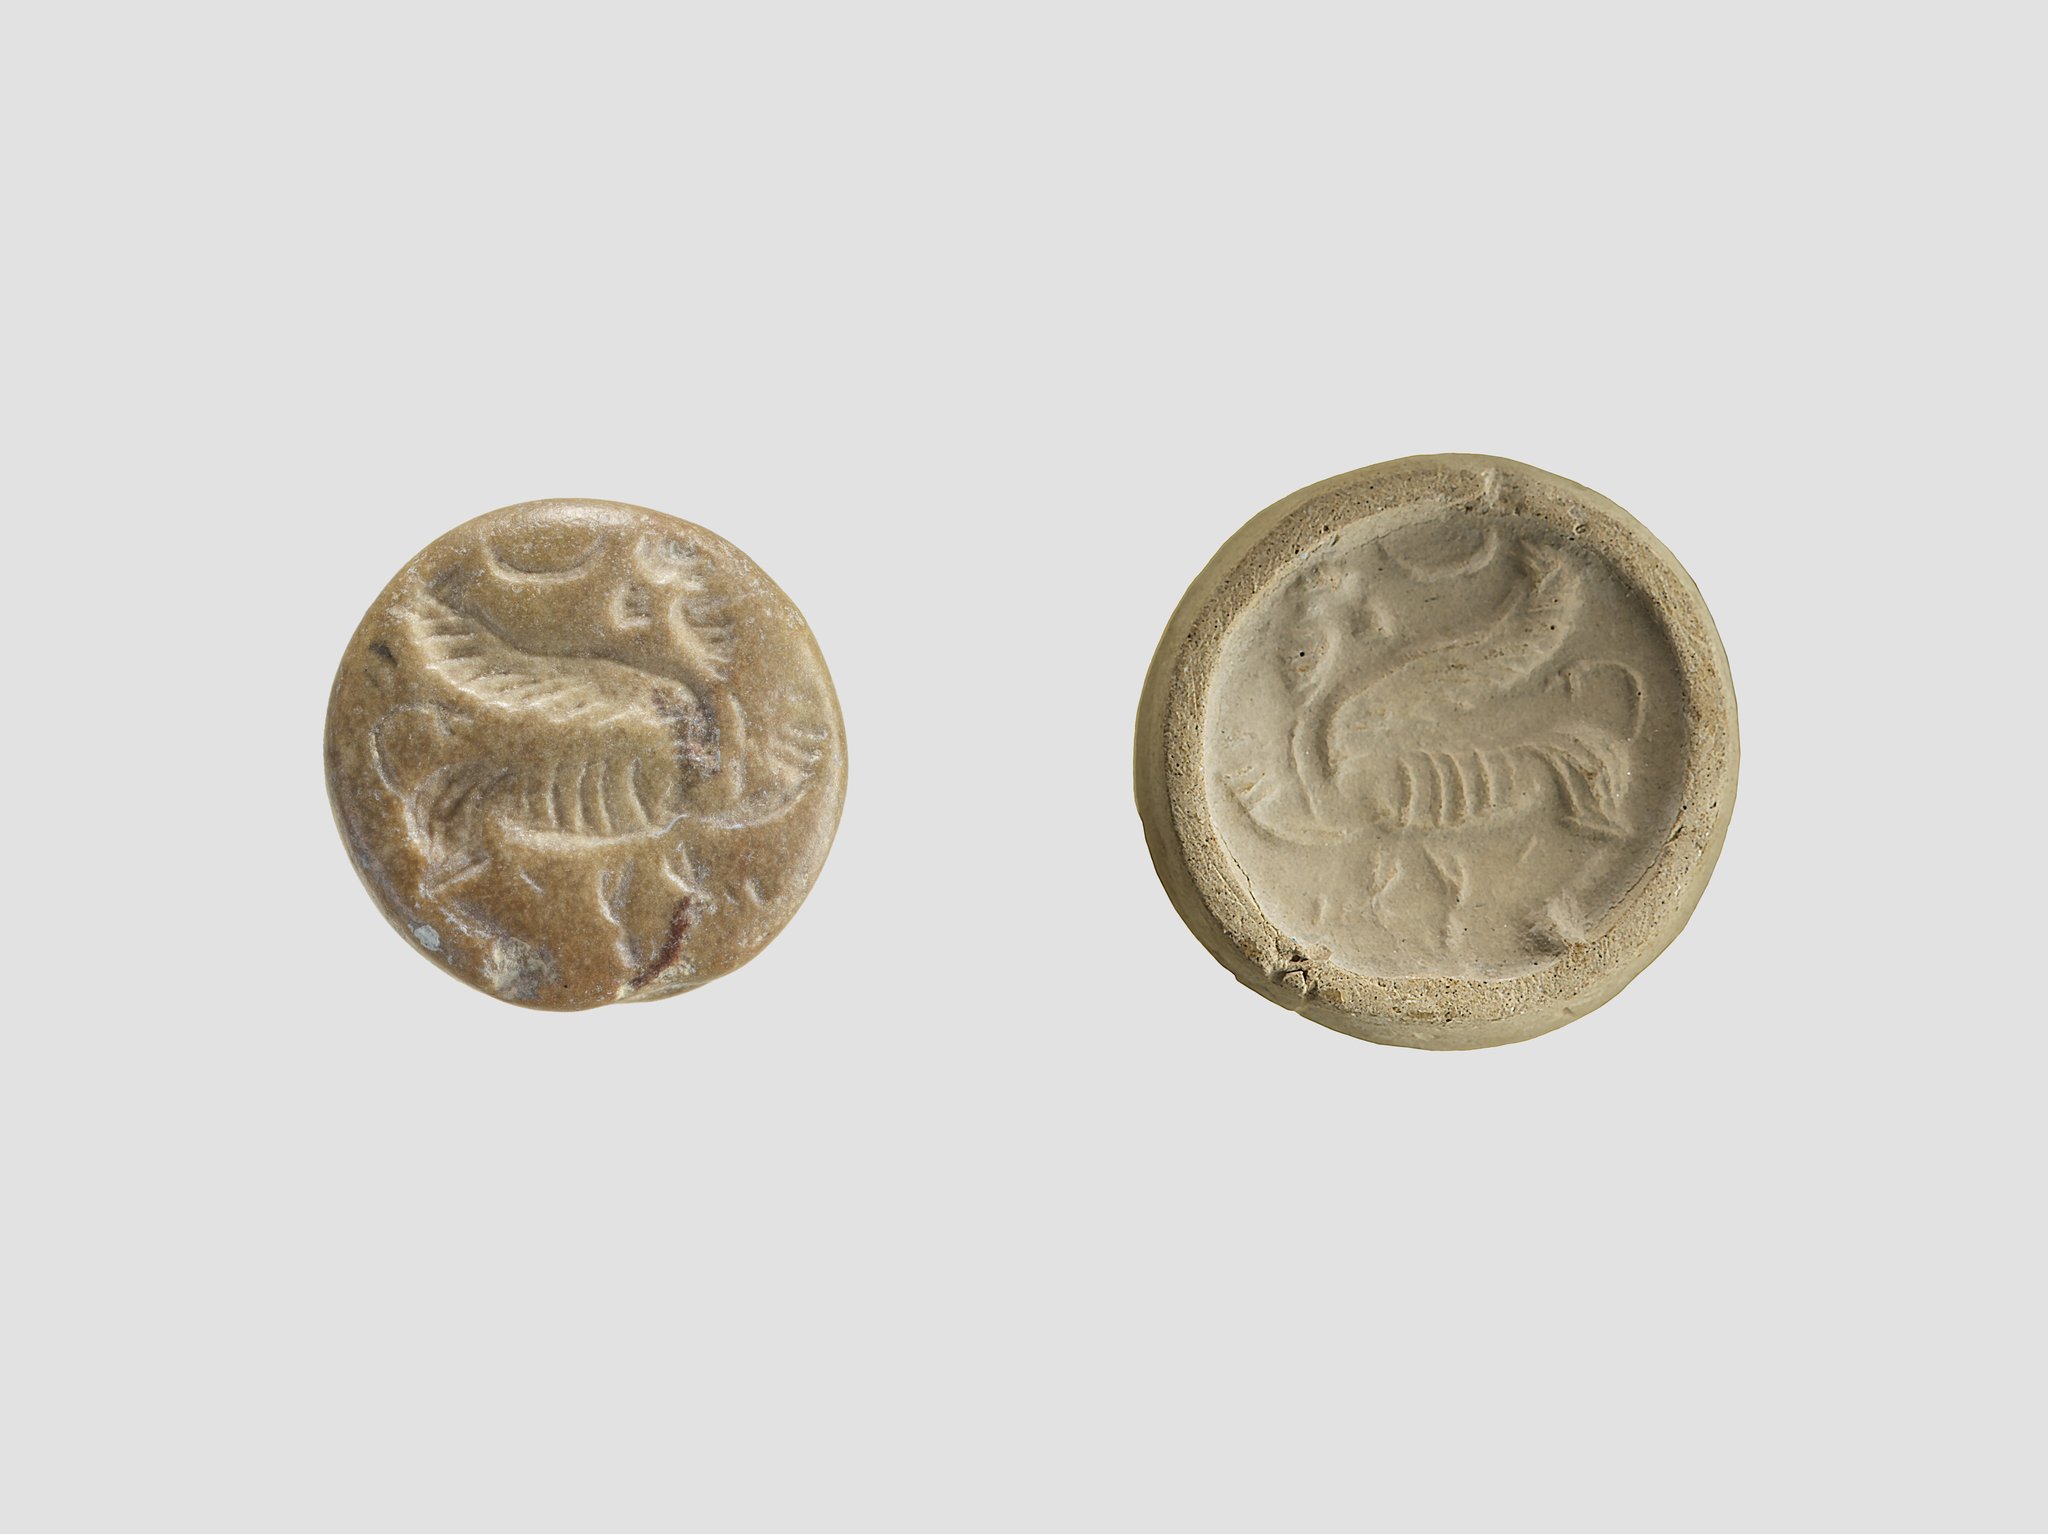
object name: stamp seal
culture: achaemenid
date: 600-301 BCE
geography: iran